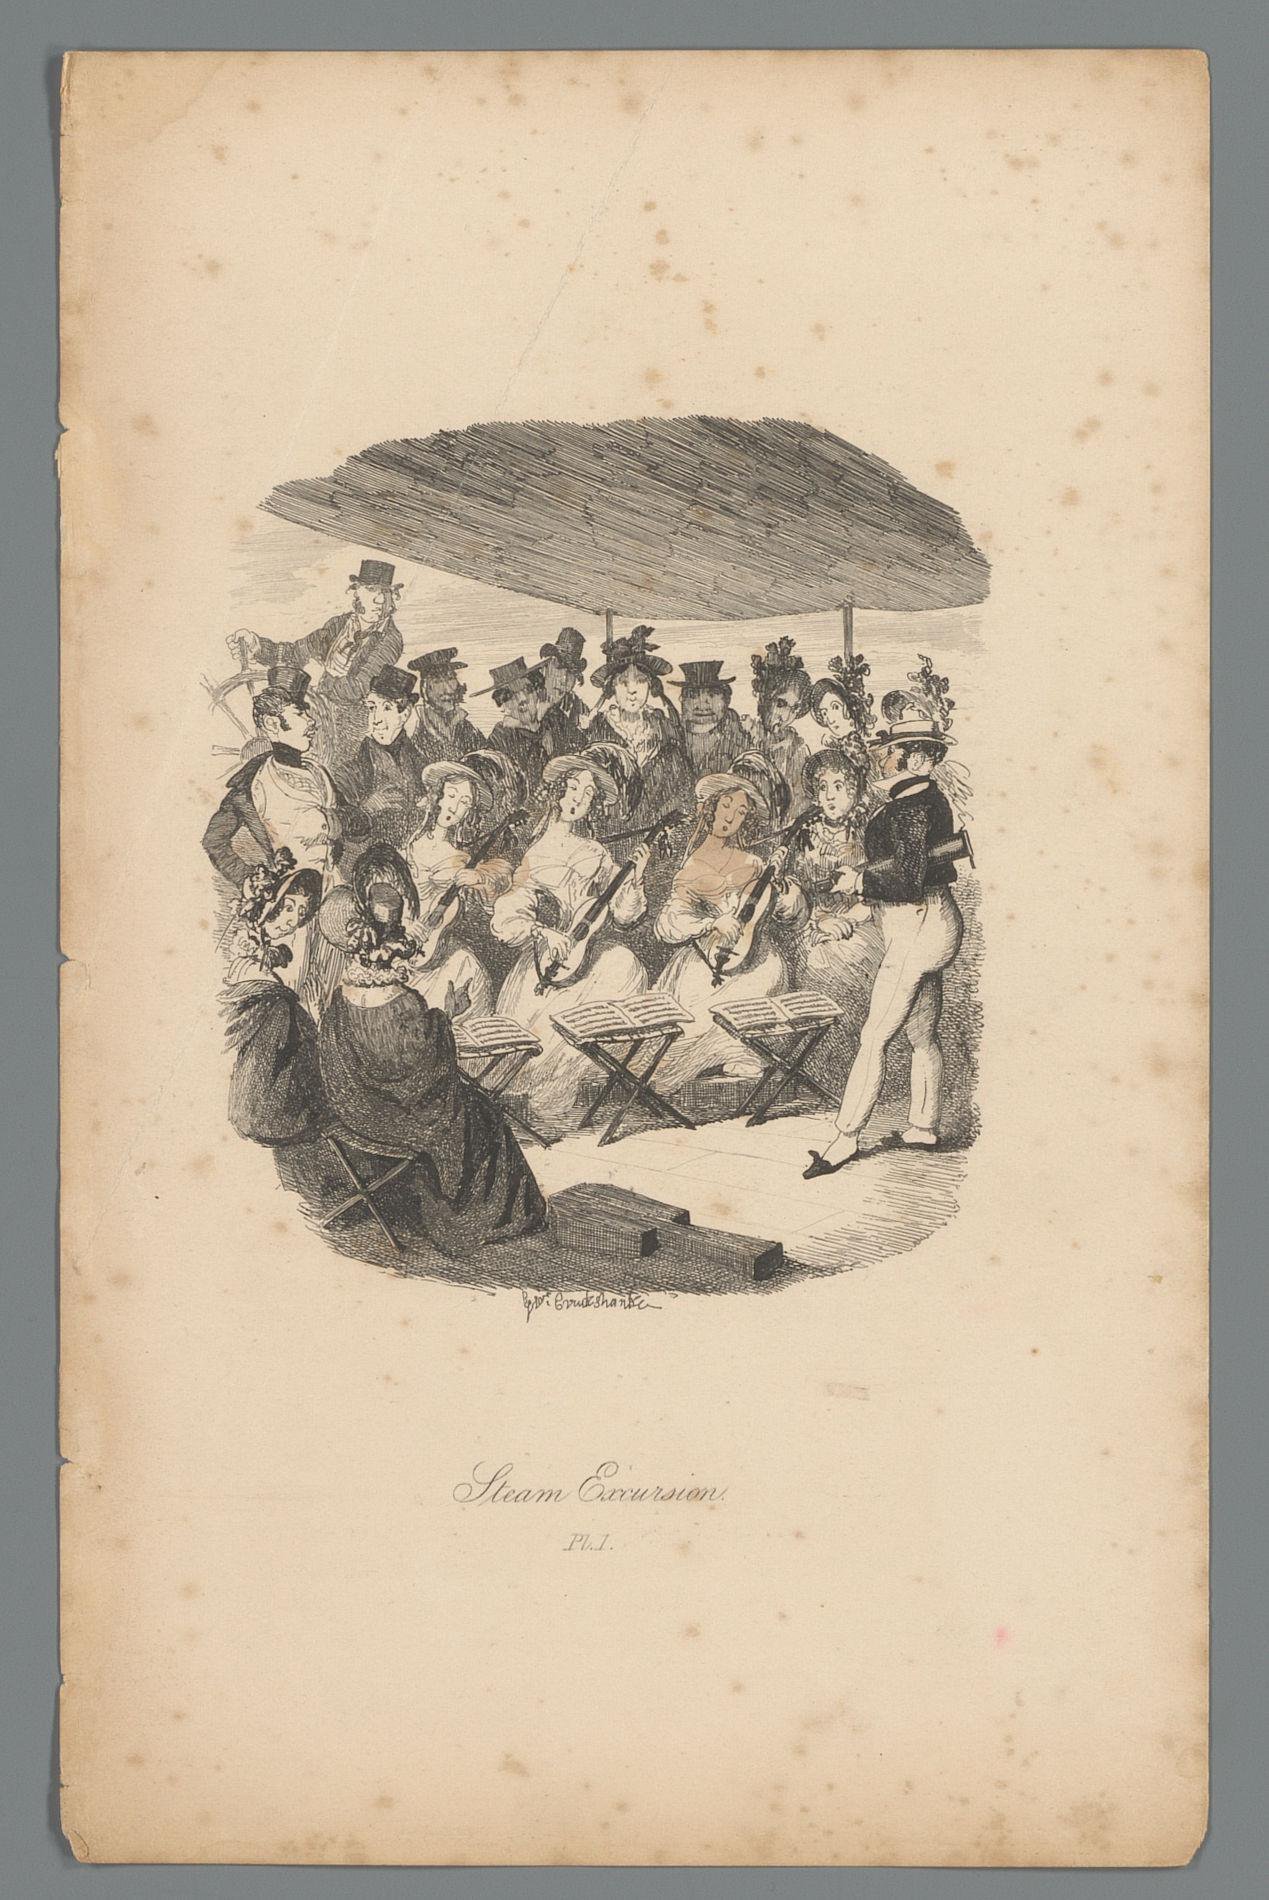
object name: cartoon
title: Steam Excursion, Pl. 1.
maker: george cruikshank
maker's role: painter, print maker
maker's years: 1792-1878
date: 1836-1839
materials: paper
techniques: etching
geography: england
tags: cithern, mandolin, guitar, balalaika - cc - out of doors, steamship, motorship (+ propulsion of vehicle, ship, etc. by steam), political caricatures and satires, small group of musicians, chamber orchestra, jazz band - cc - 'concert champêtre'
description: Een orkestje van drie dames met gitaren speelt muziek voor de reizigers op het dek van een stoomboot. Illustratie voor een uitgave van Sketches by 'Boz' van Charles Dickens, 1836-1839.